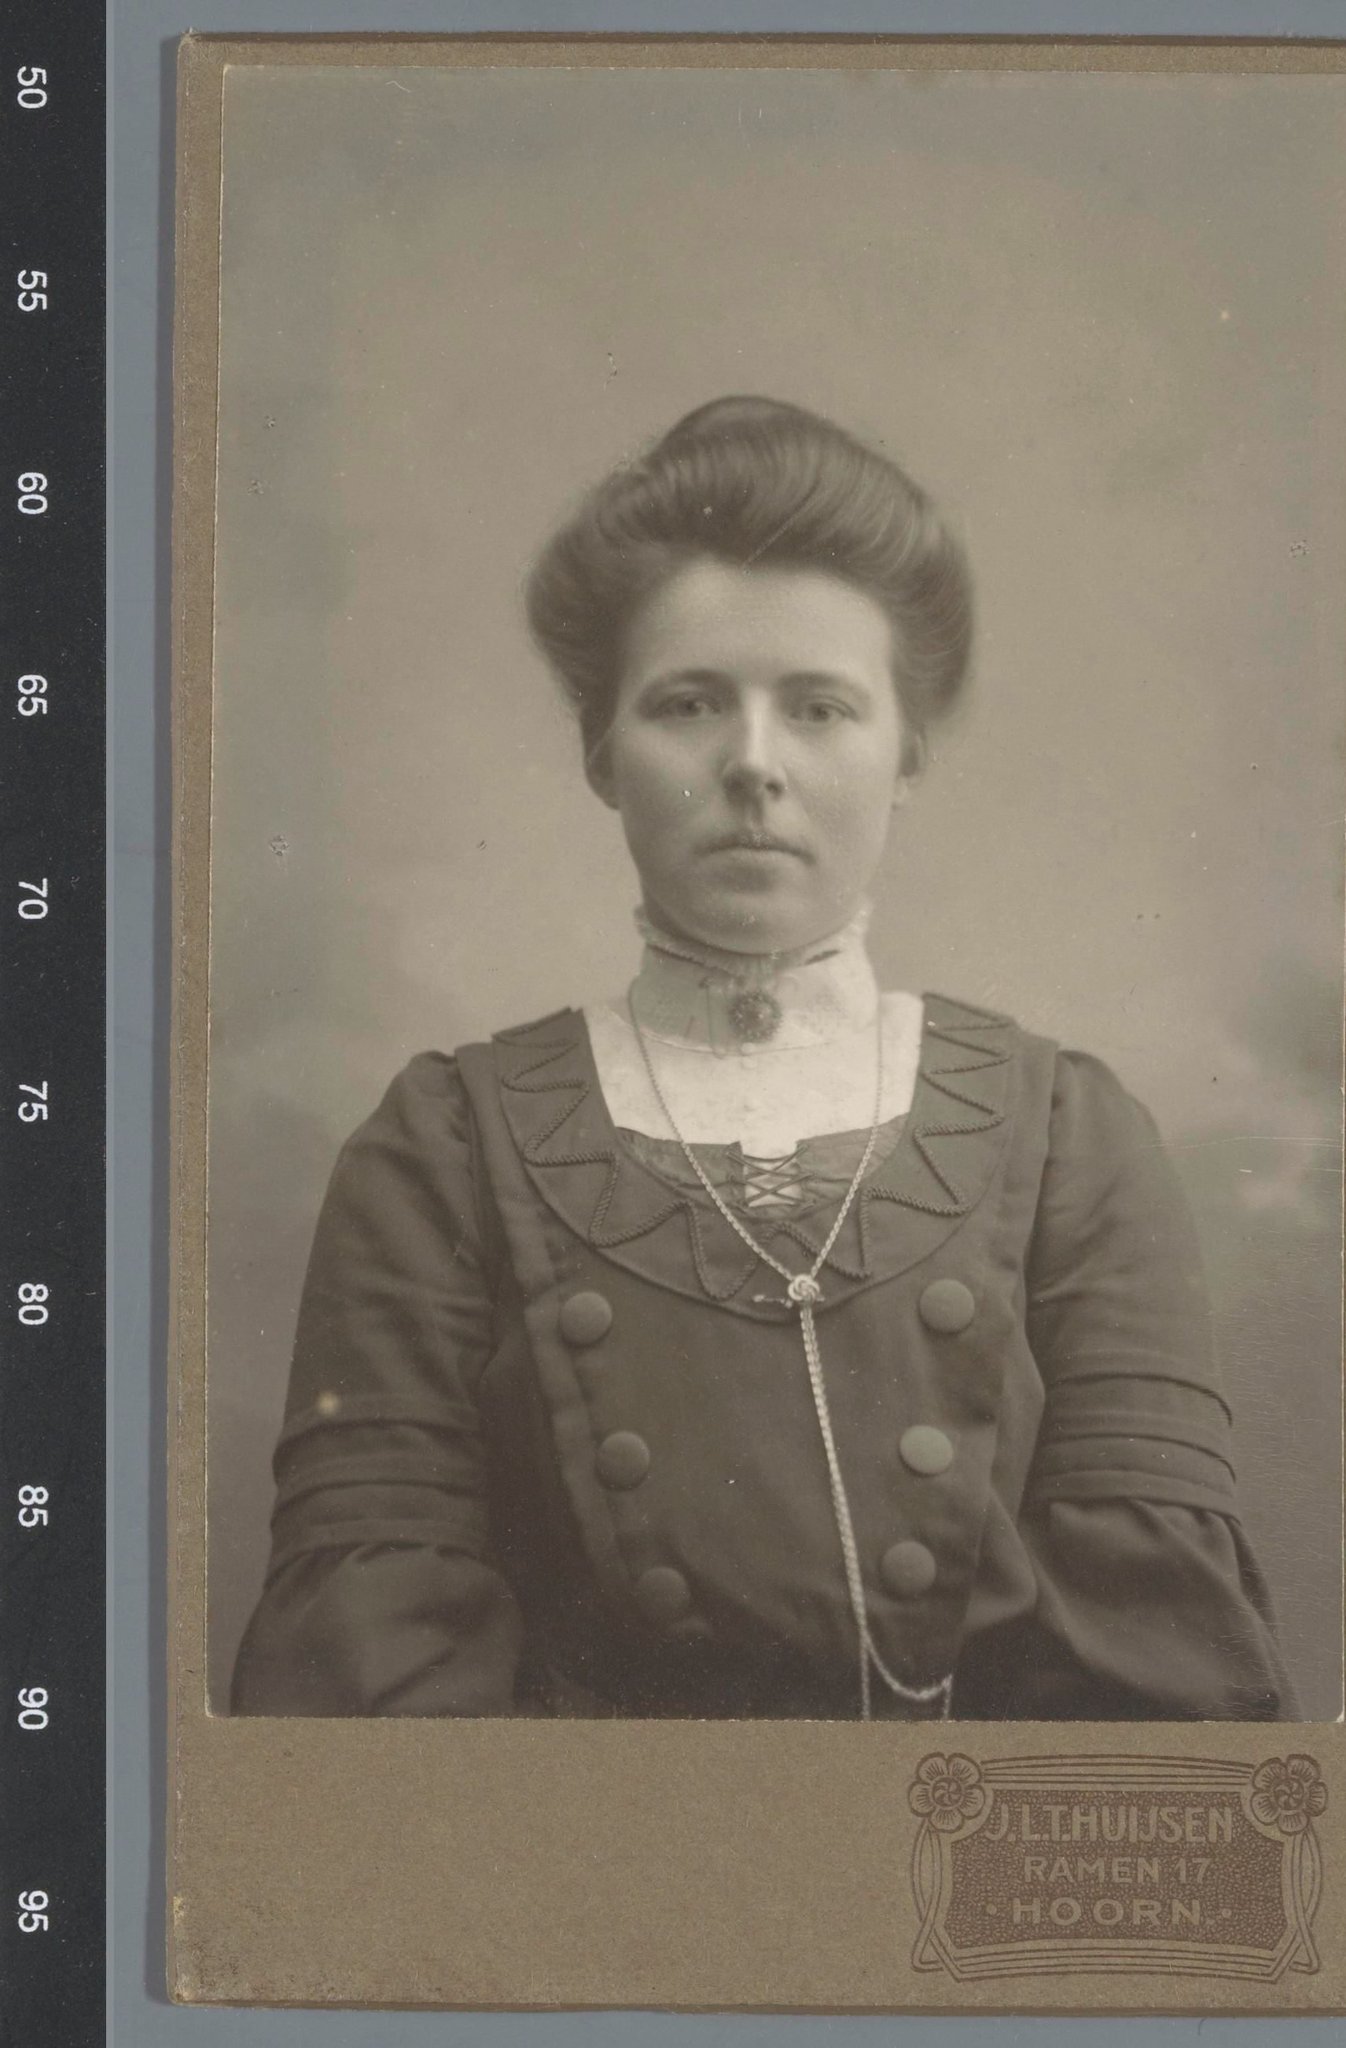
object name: carte de visite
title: Portret van Ma Tobben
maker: johannes laurens theodorus huijsen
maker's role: fotograaf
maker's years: 1852-1910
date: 1900-1910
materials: paper, cardboard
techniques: gelatin silver print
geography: hoorn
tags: adult woman, historical persons, hoorn (north holland)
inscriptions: inscription: ‘De plaat blijft ter/ nabestelling bewaard.’, address: ‘HOORN/ Ramen 17.’